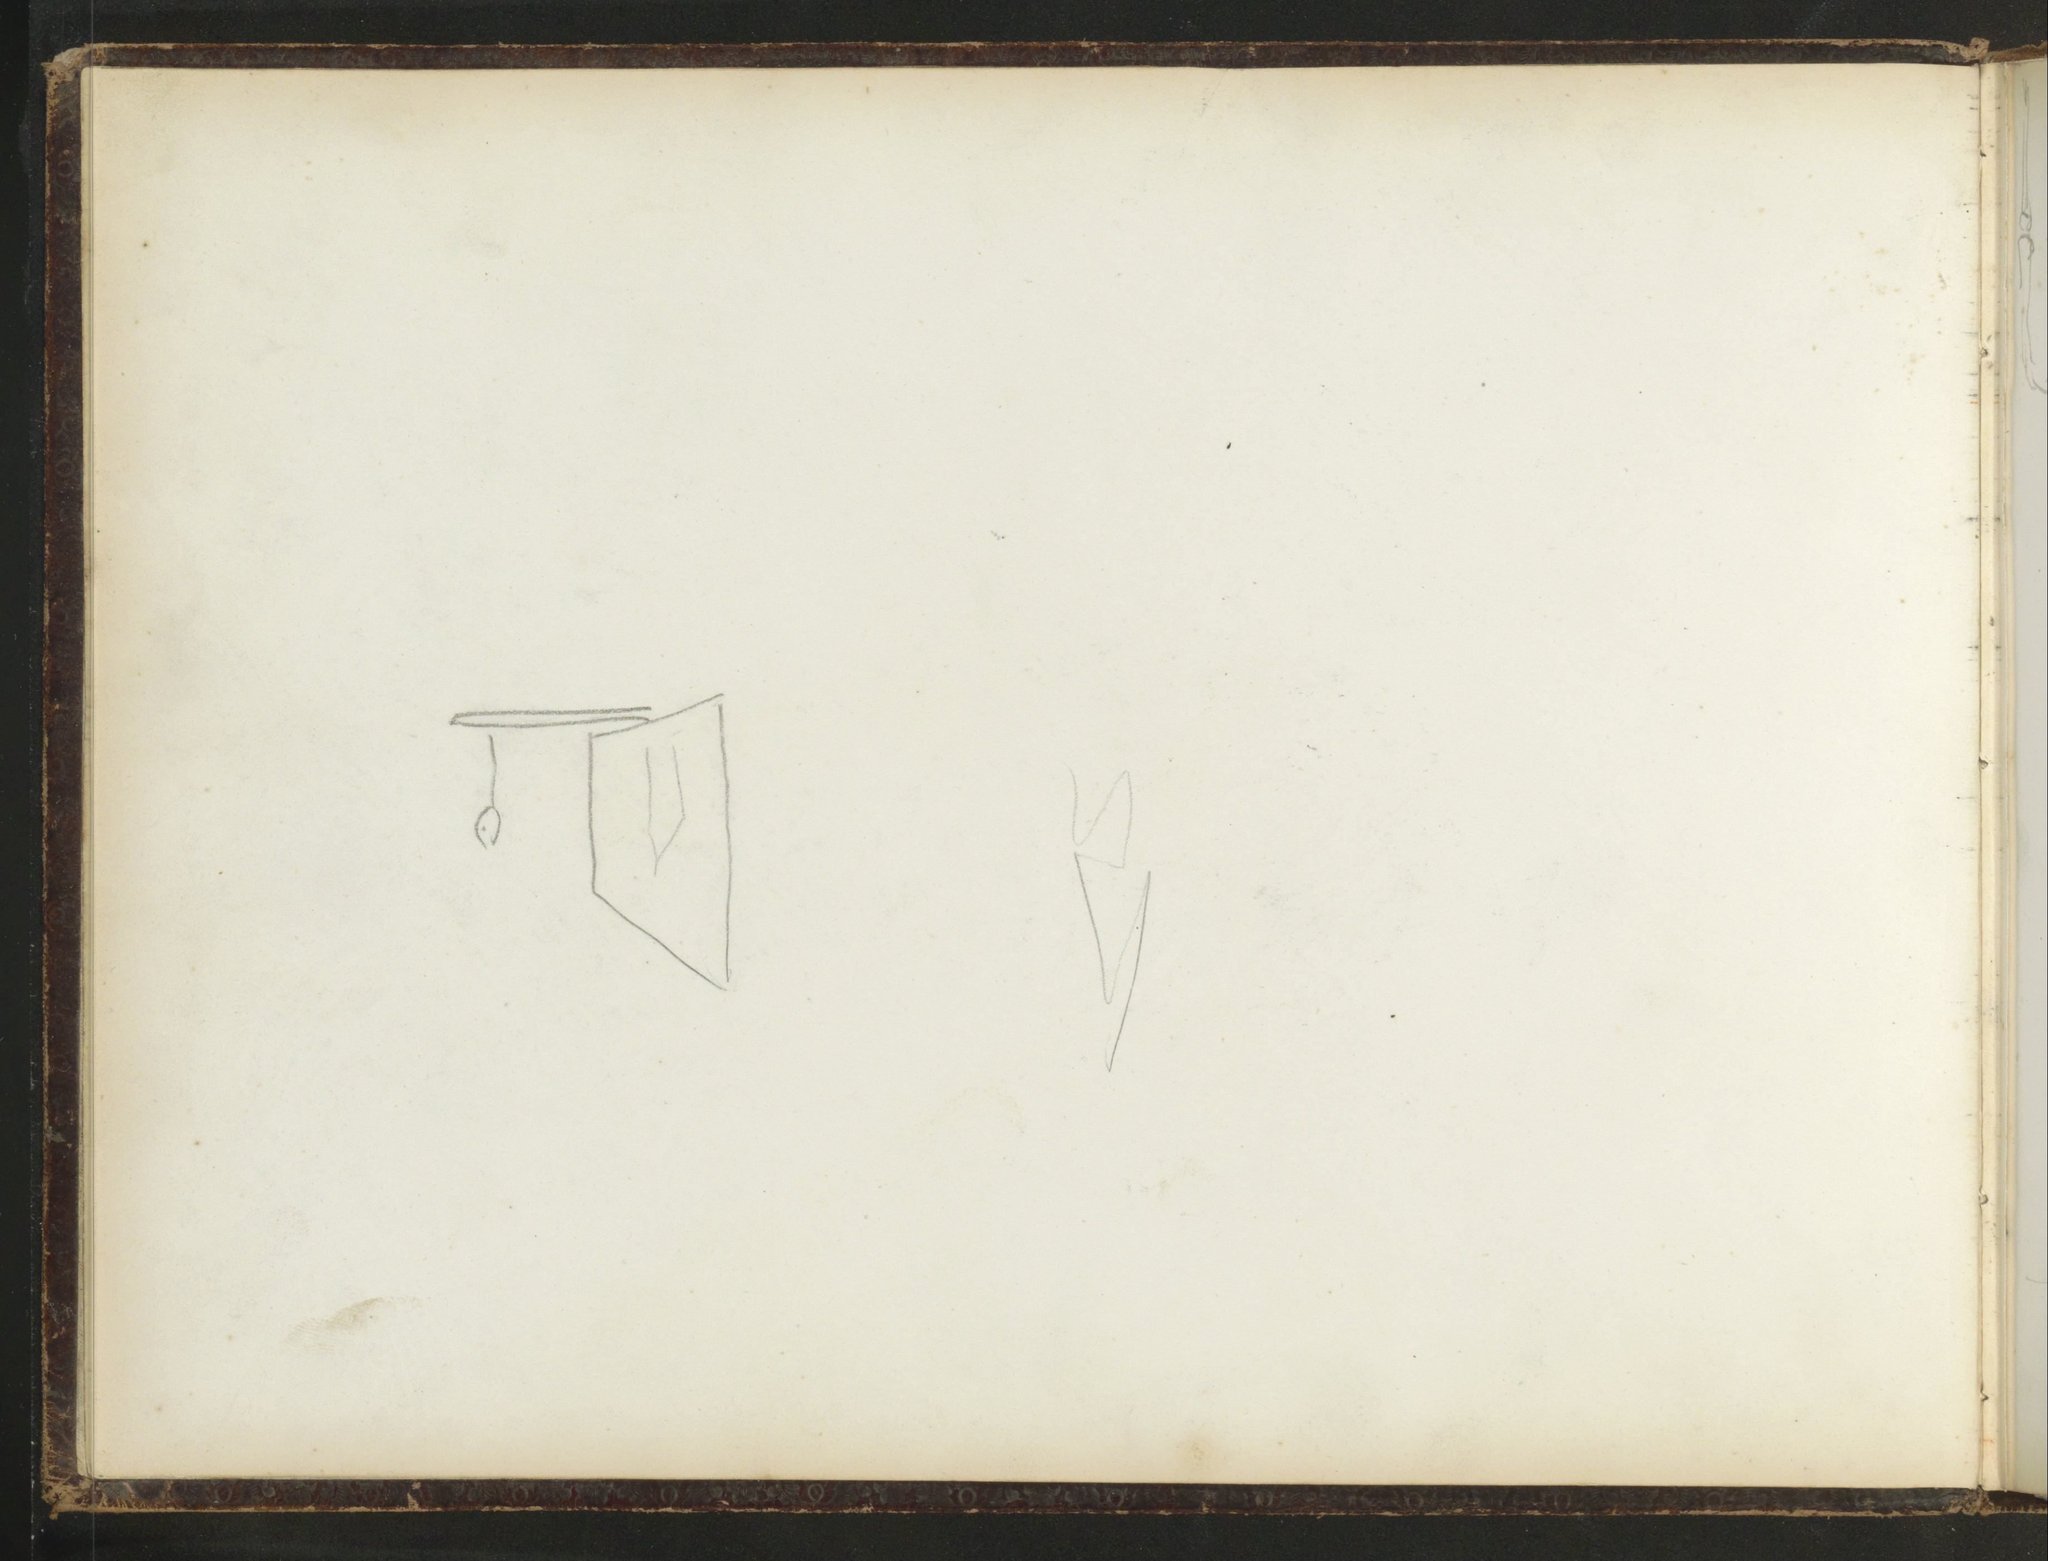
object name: endleaf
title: Studies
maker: reinier craeyvanger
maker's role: draughtsman, print maker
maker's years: 1812-1880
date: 1822-1880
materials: paper, pencil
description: Blad 1 verso, voorste vrije schutblad, uit een schetsboek met 45 bladen.